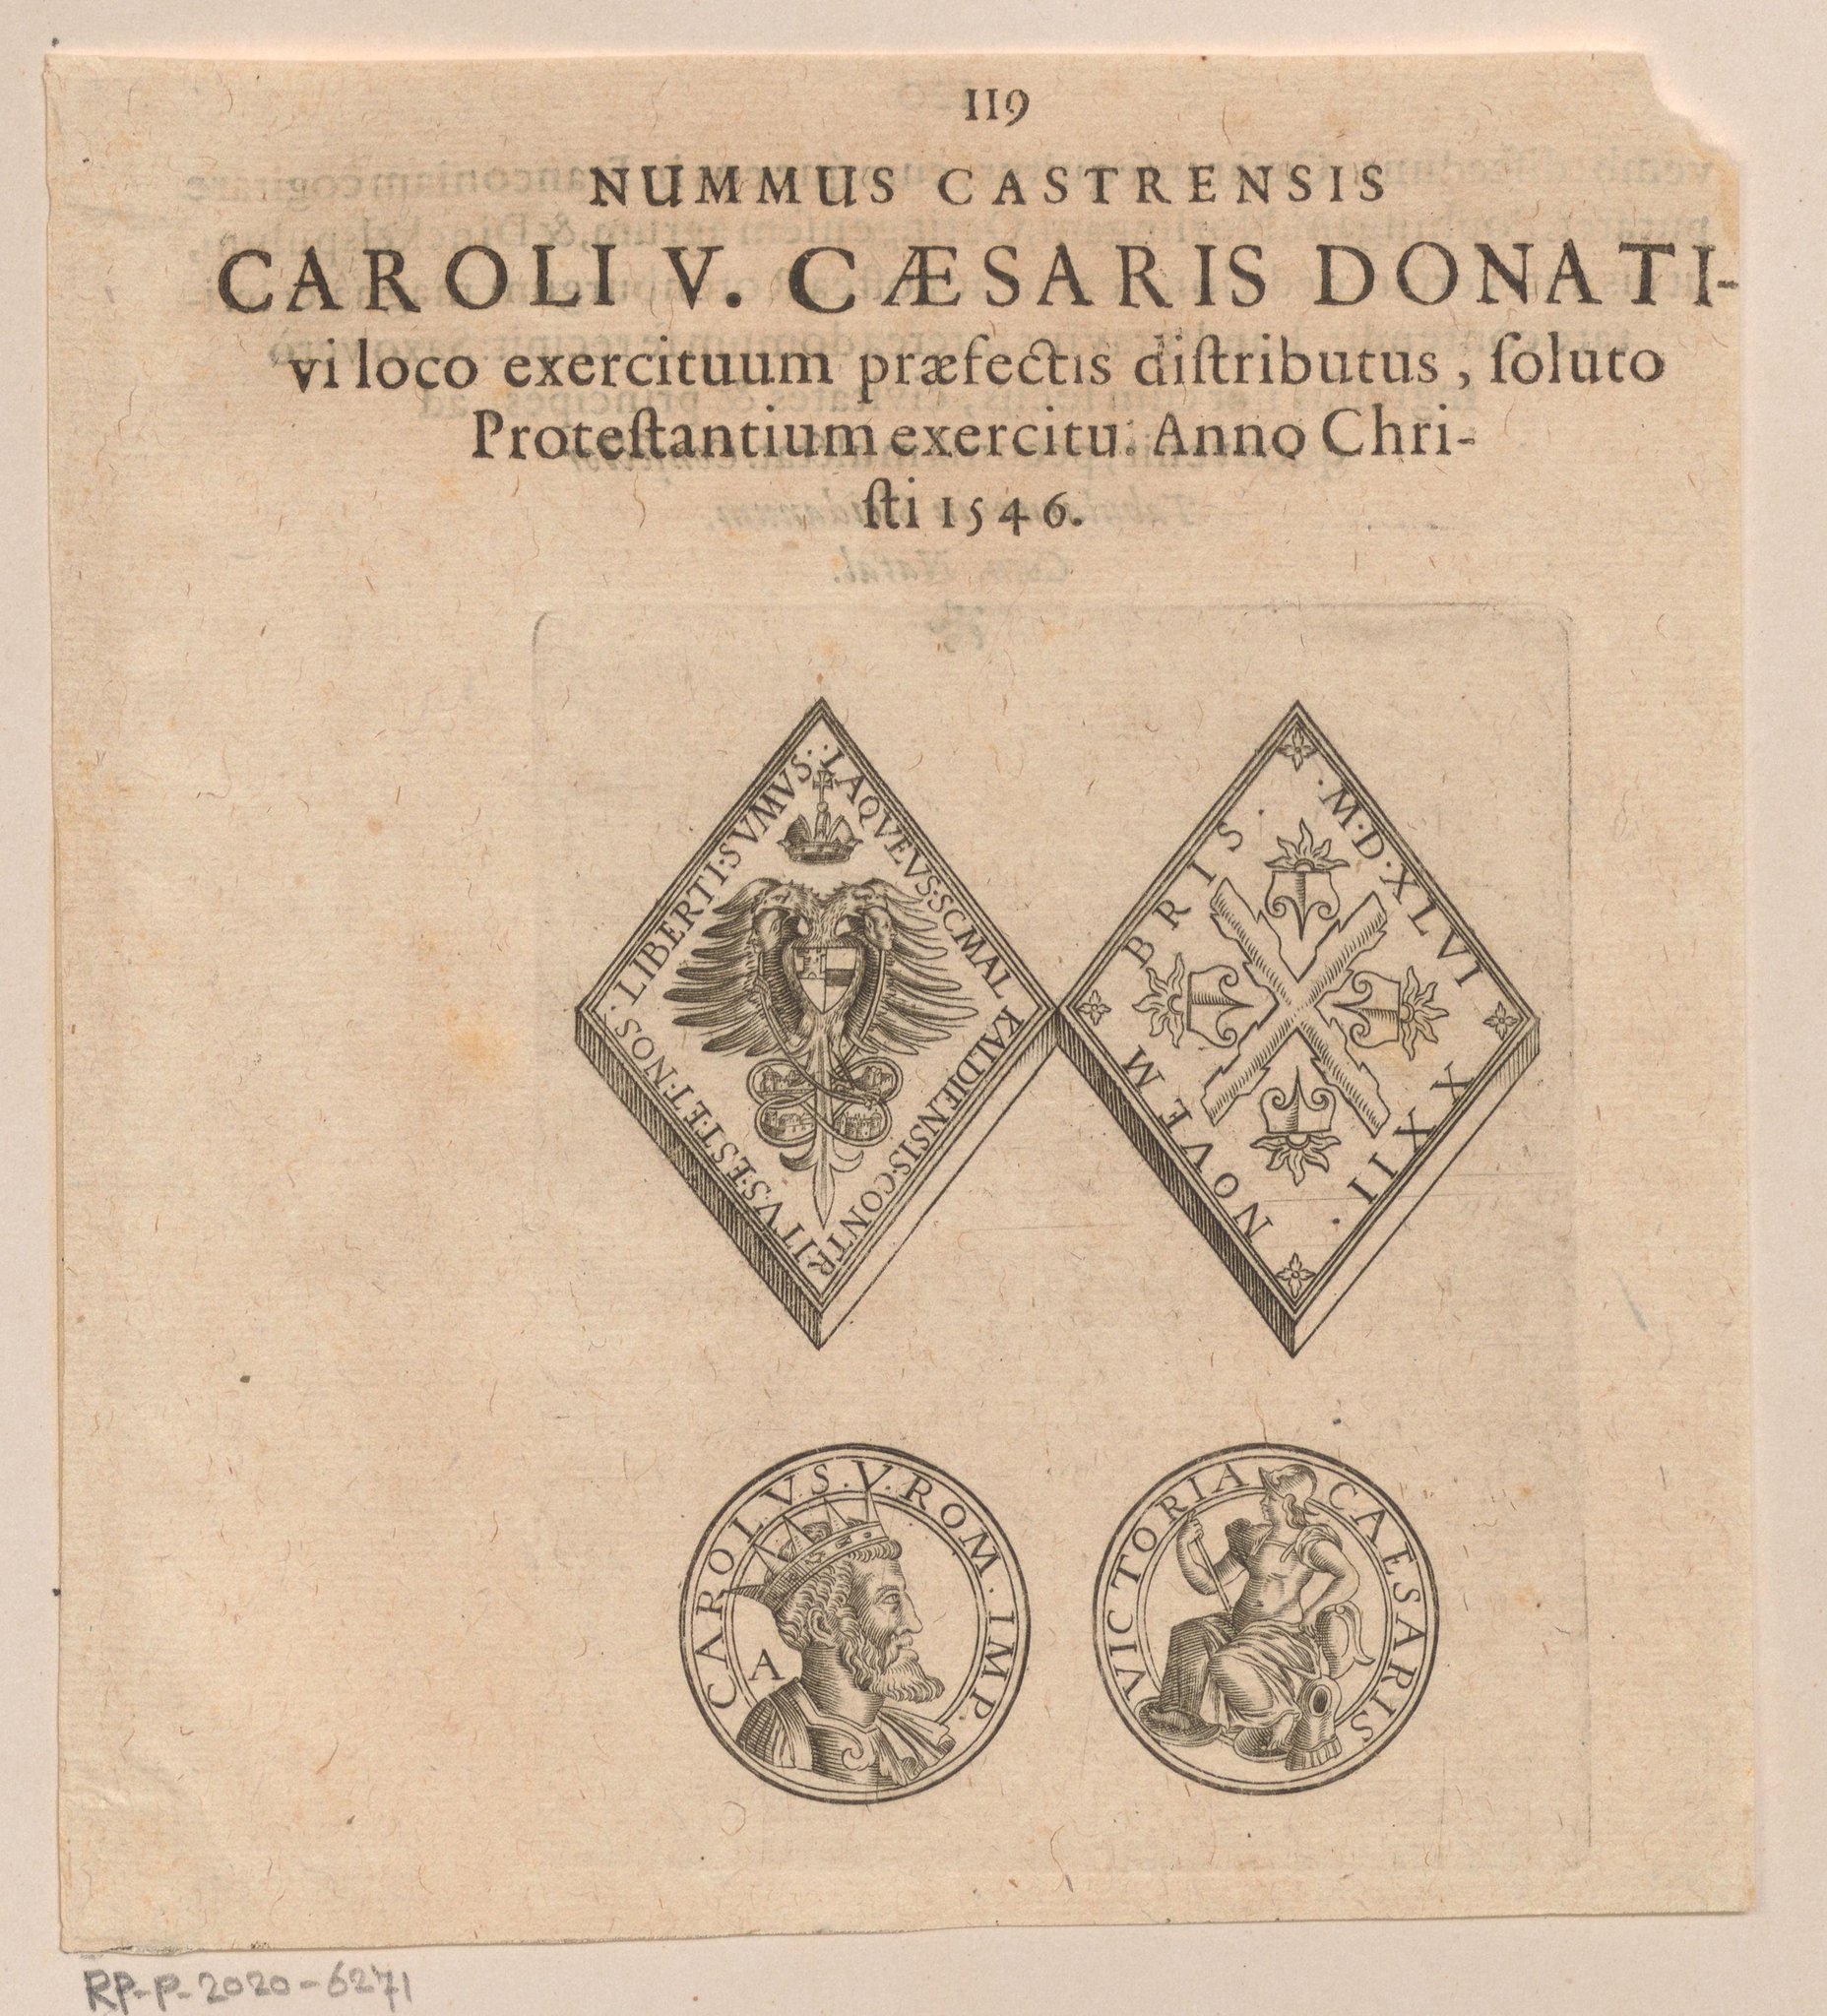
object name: book illustration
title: Medaille met het portret van keizer Karel V en zijn wapen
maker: Anonymous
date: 1620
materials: paper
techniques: engraving, letterpress printing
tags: ghent, charles v (holy roman emperor and king of spain), predatory birds: eagle, historical persons, king, armorial bearing, heraldry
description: Prent uit: Luck, Johann Jacob. Sylloge numismatum elegantiorum quae diuersi (...). S.l.s.n.,1620, p. 84.